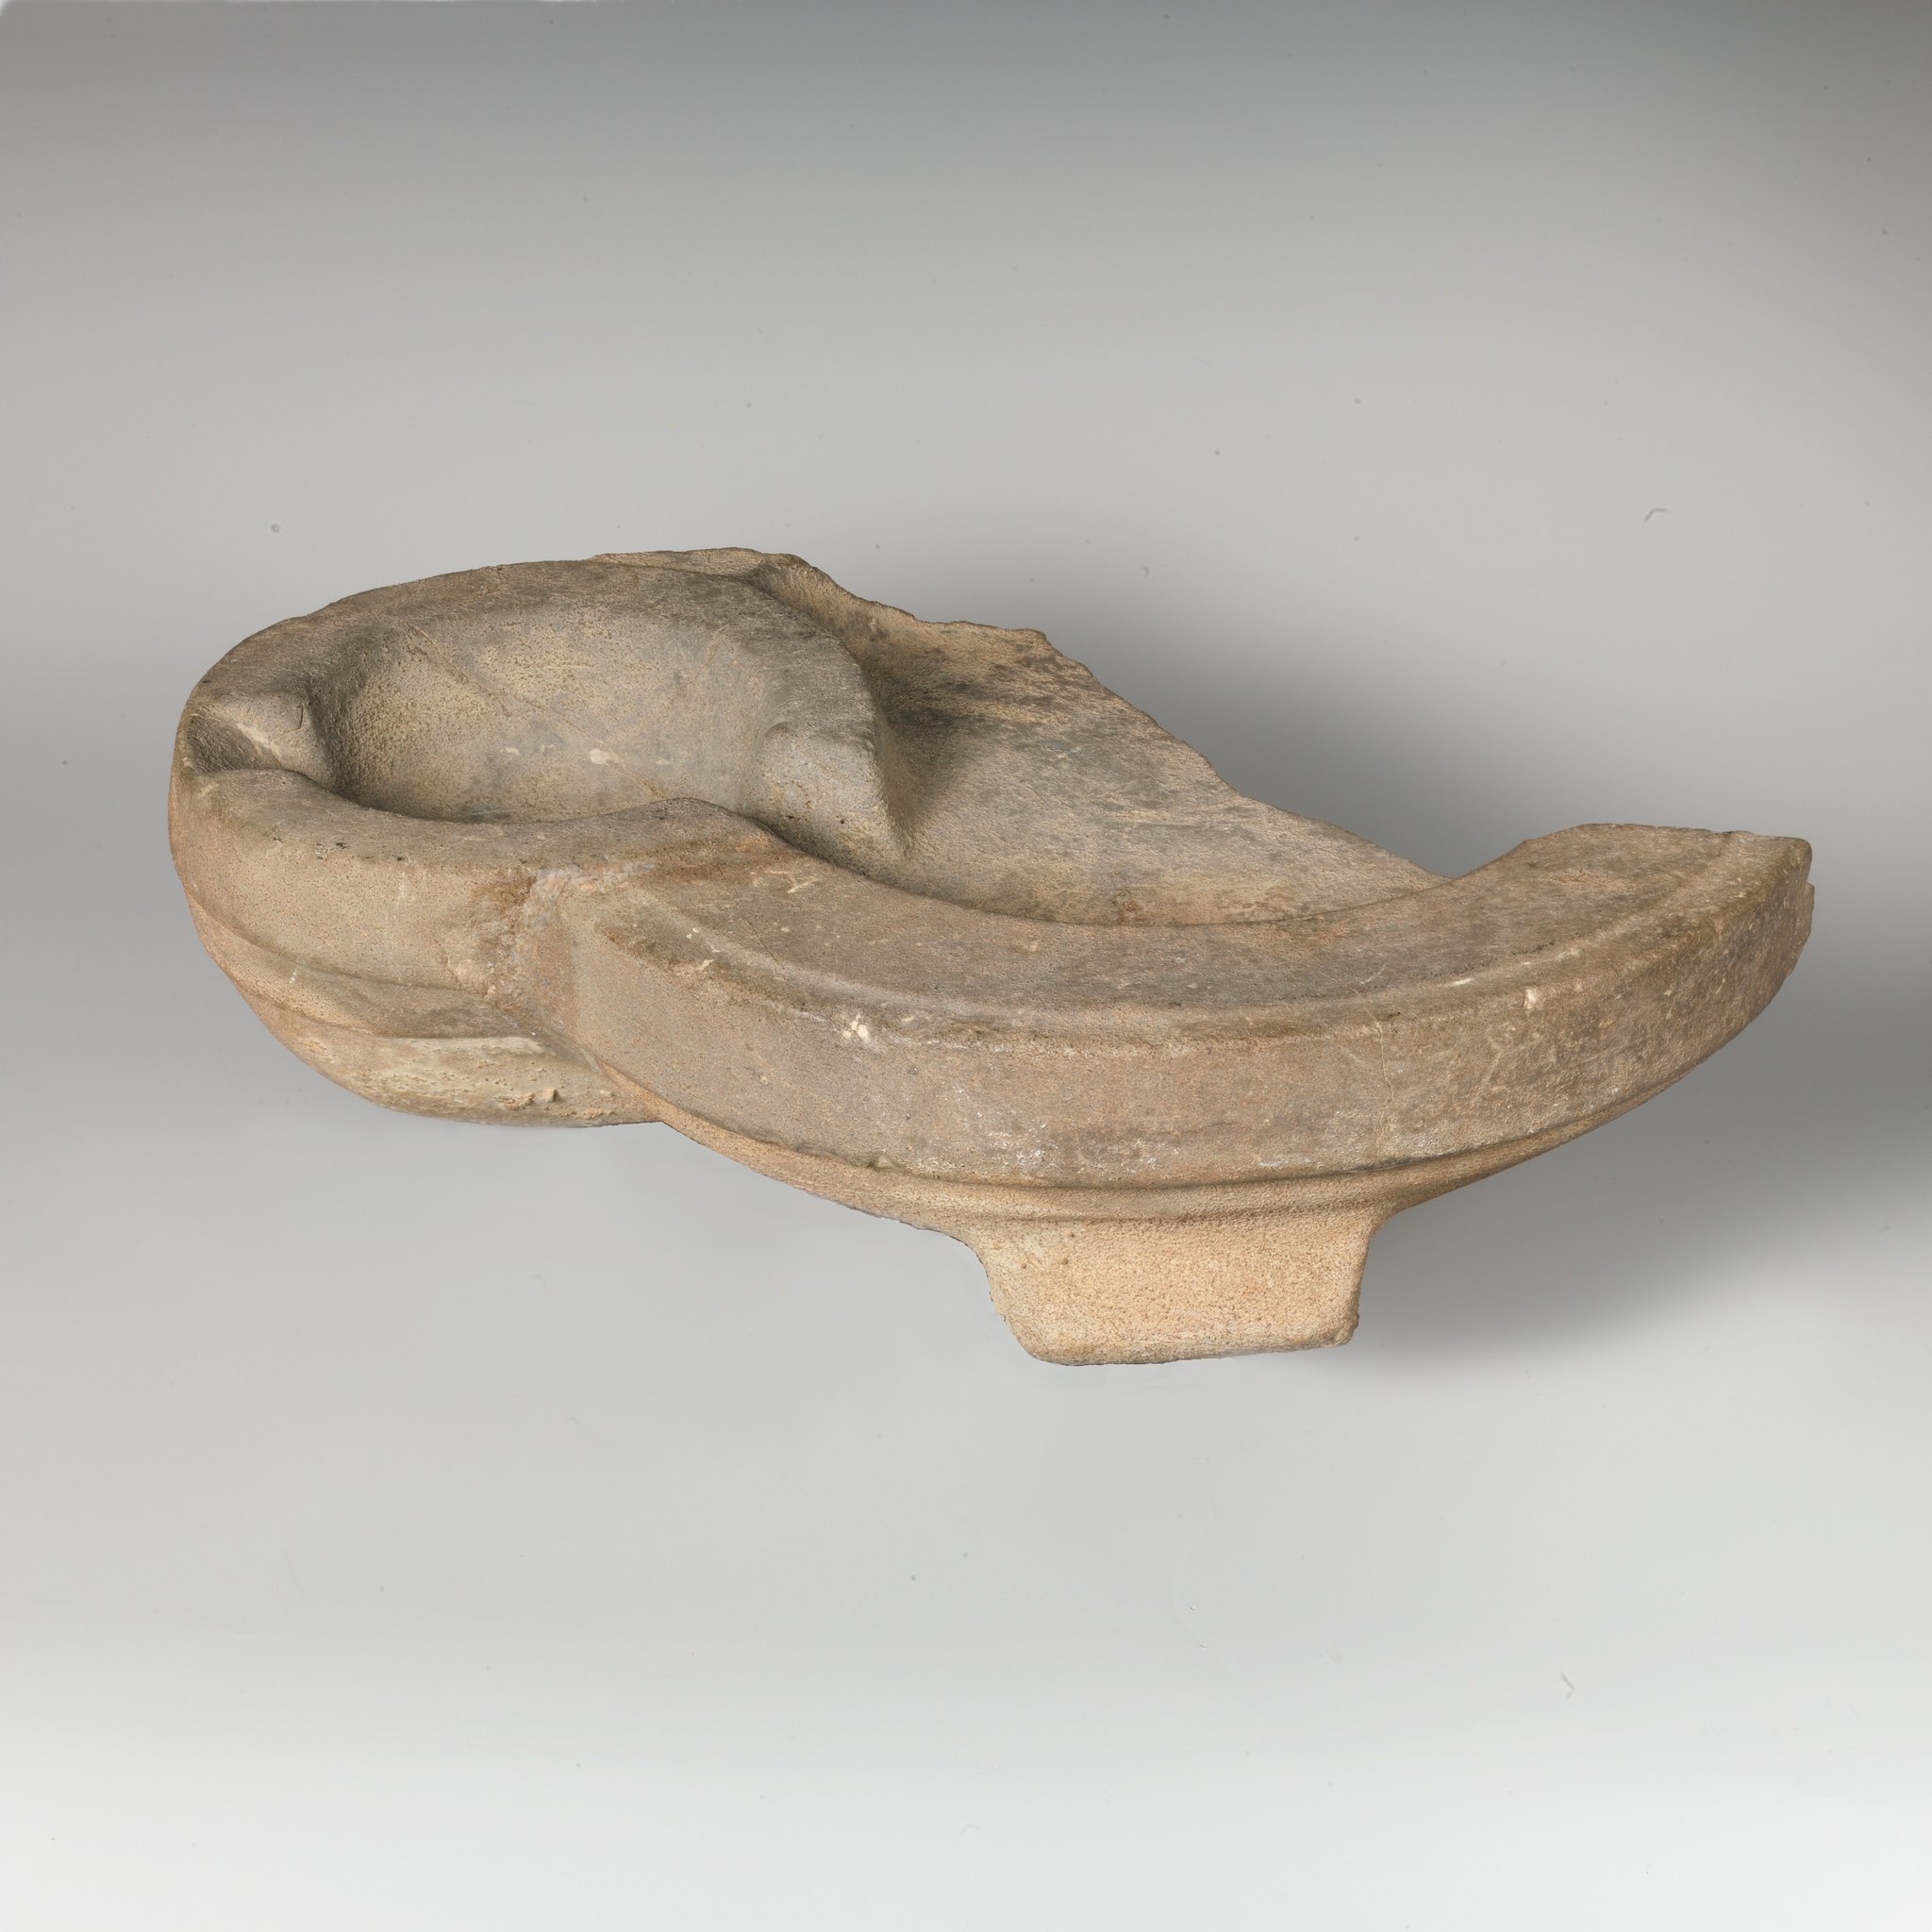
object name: lamp fragment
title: Fragmentary stone oil lamp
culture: minoan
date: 1750-1450 BCE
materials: stone